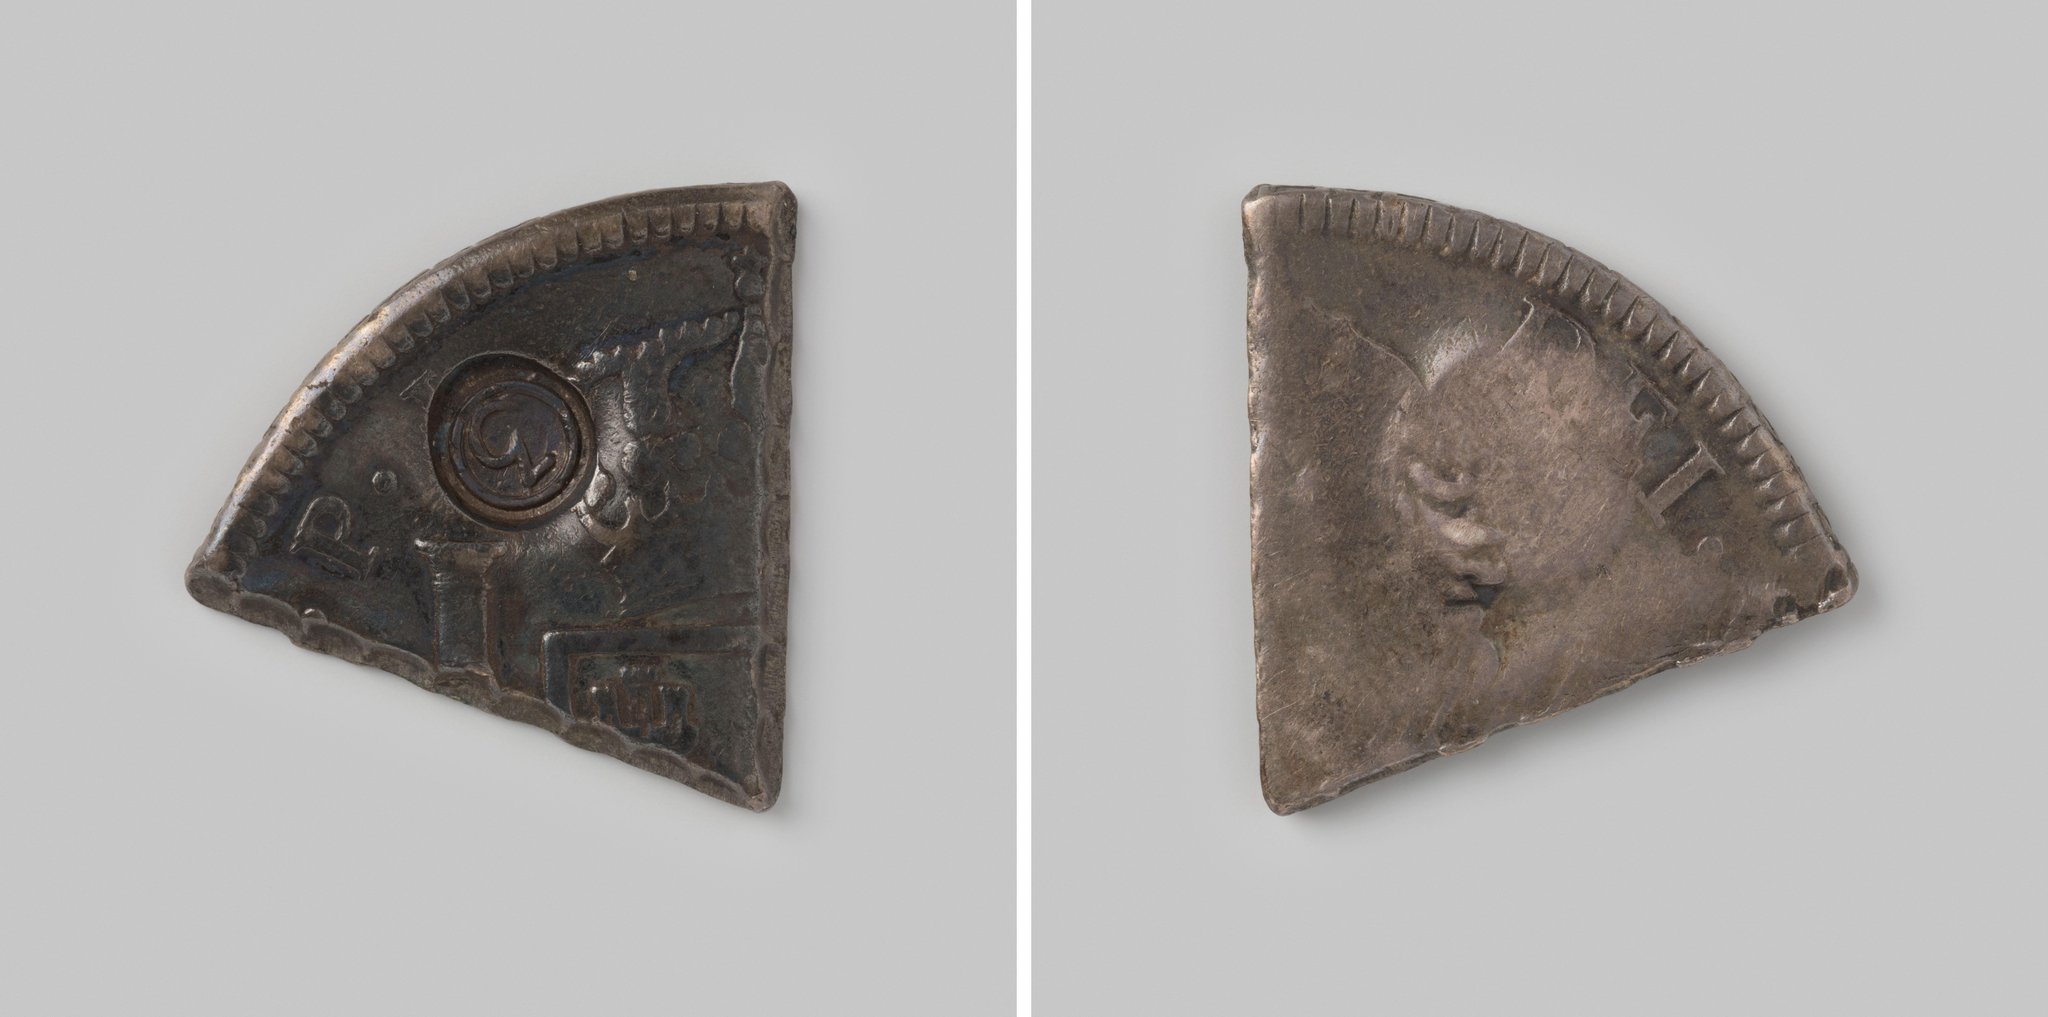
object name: coin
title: Driekantje van 3 reaal uit een Spaanse pilaardollar (acht reaal) of Spaanse mat voor Curaçao, [1818]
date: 1818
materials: silver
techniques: striking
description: Zilveren munt, een vijfde gedeelte van een in vijf delen gekapte Spaanse pilaardollar, zogenaamd driekantje. Voorzijde: gedeelte van het gekroonde Spaanse wapenschild en van een zuil [pilaar]. Daarin gestempeld, geklopt: cijfer 3 binnen een cirkel. Keerzijde: gedeelte van een hoofd naar rechts. Bloemrand en kartelrand.